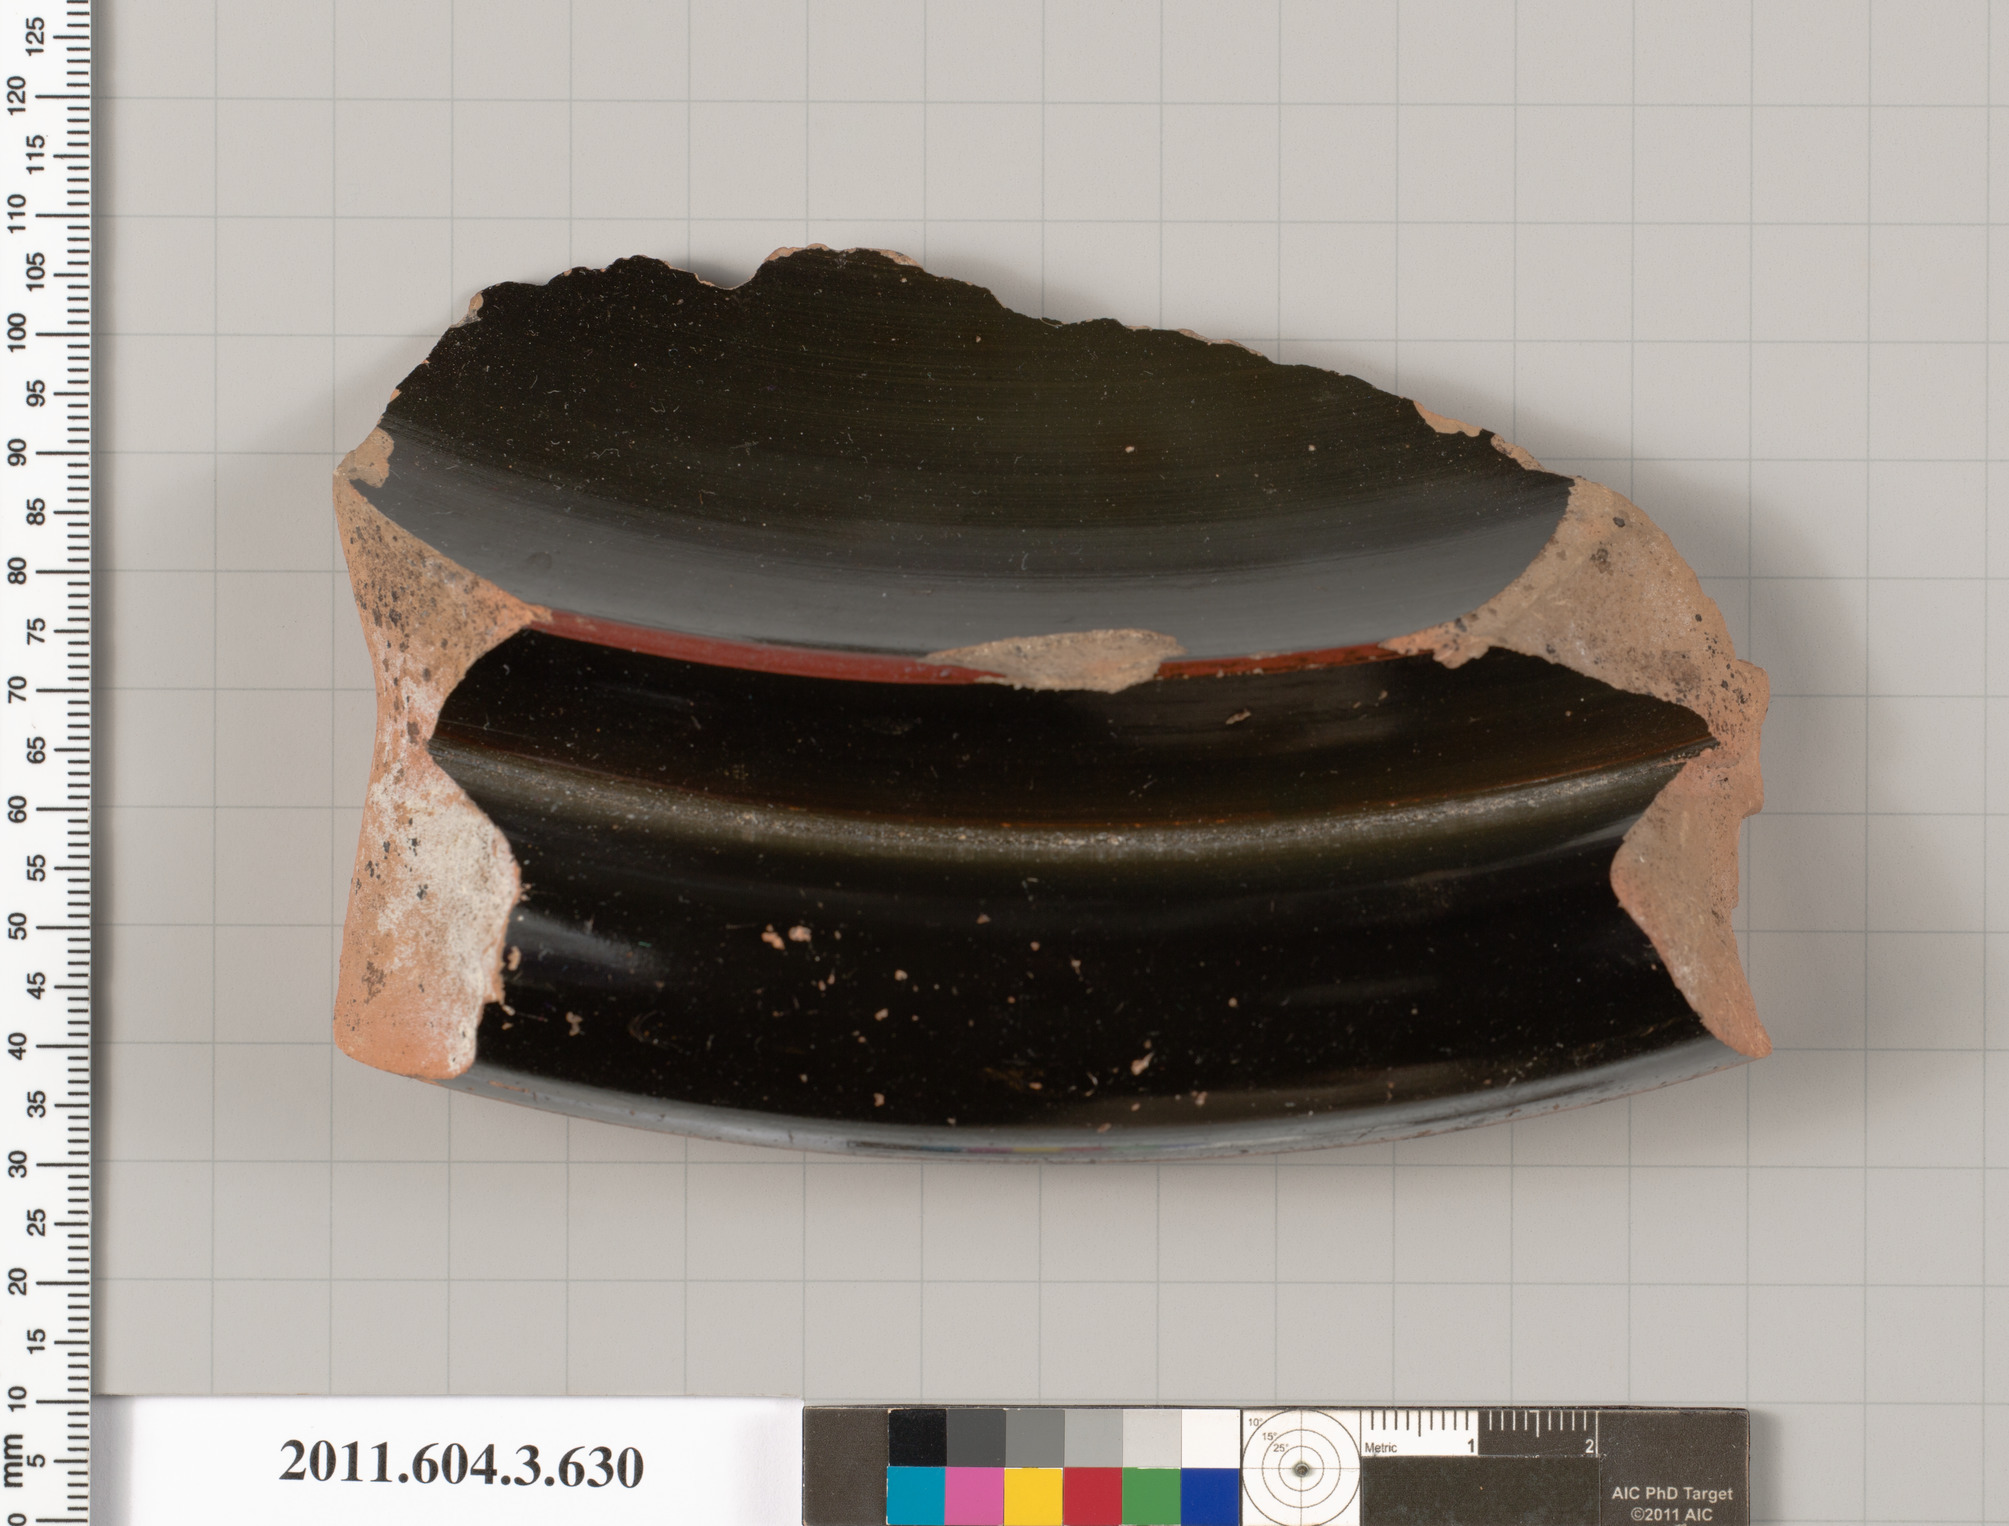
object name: calyx krater fragment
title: Terracotta fragment of a calyx-krater (bowl for mixing wine and water)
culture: greek, attic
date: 600-401 BCE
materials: terracotta